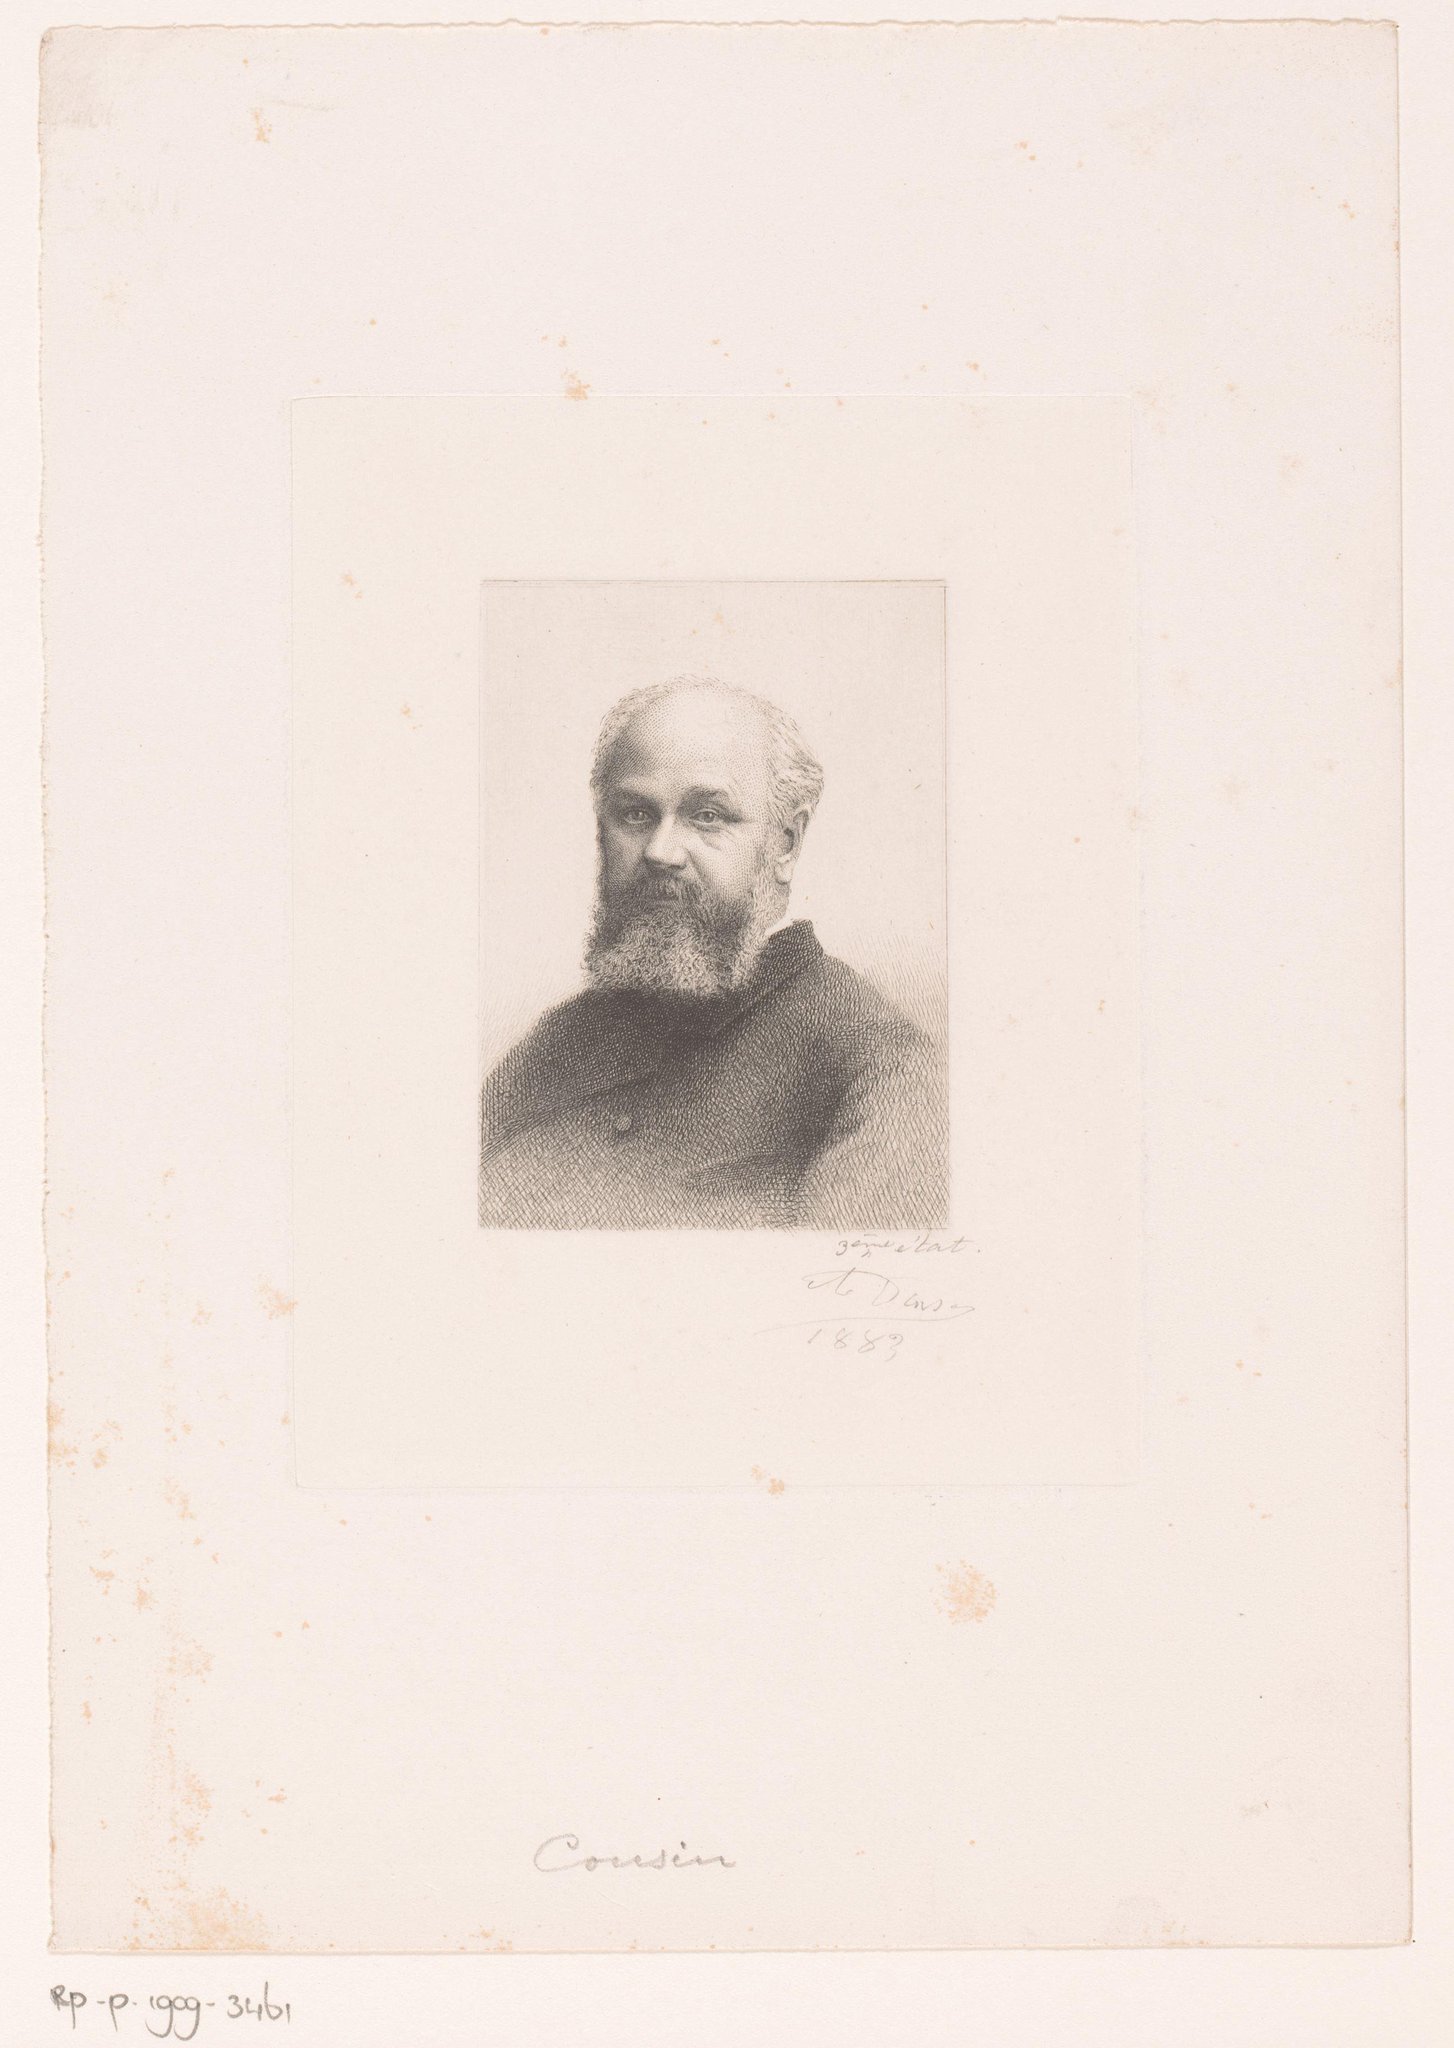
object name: print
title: Portret van een onbekende man, mogelijk Cousin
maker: auguste danse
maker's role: print maker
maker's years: 1829-1929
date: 1883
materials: paper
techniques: etching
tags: historical person (...) - historical person (...) portrayed alone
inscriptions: annotation: ‘3ème état’, collector's mark: Lugt 2228